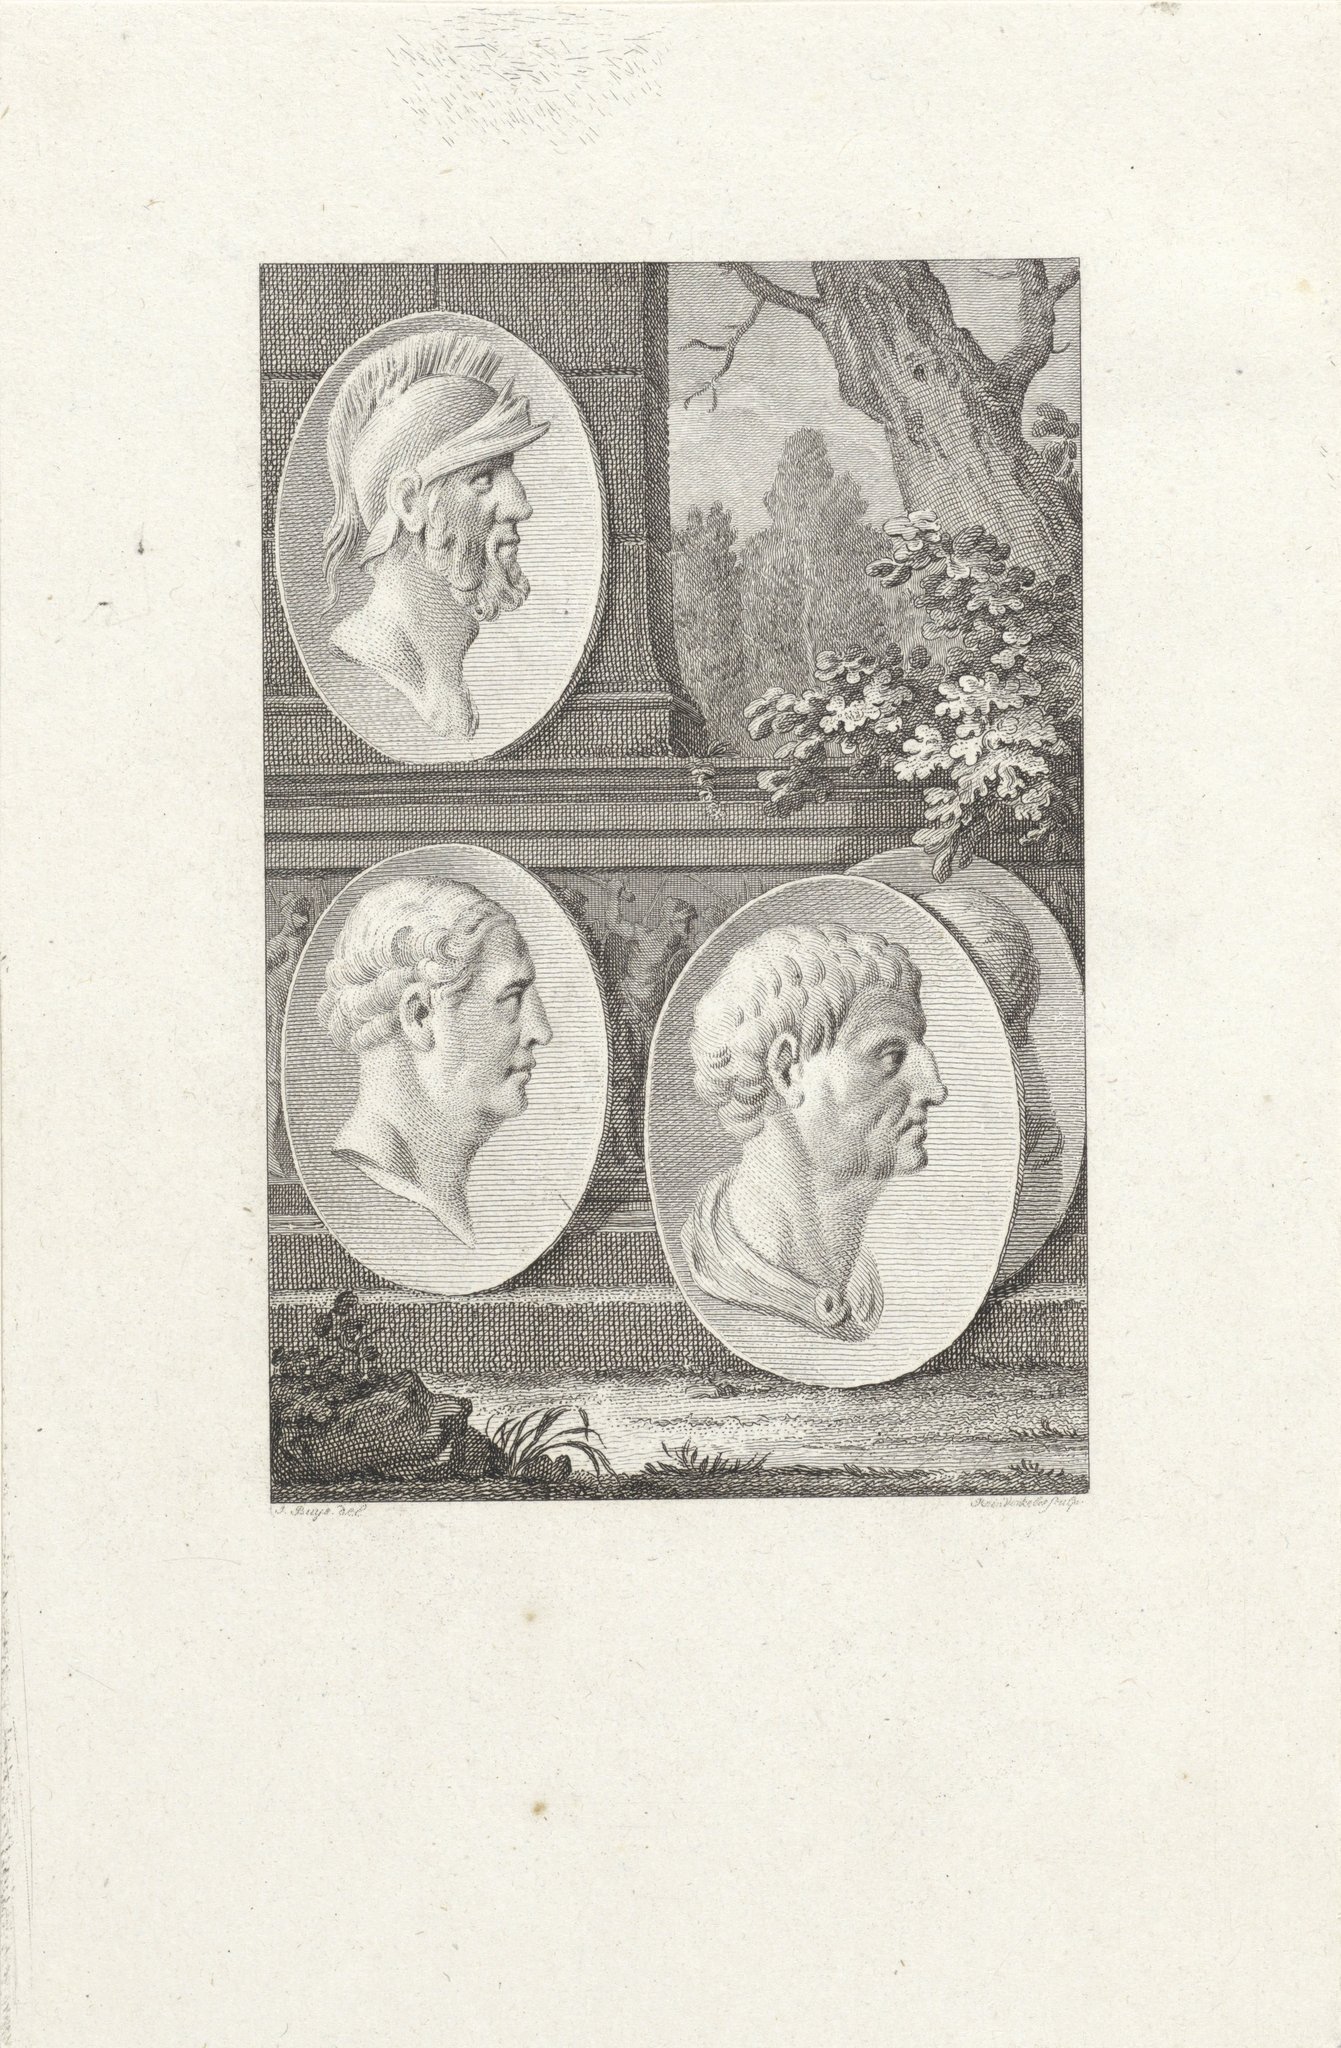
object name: print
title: Medaillons met portretten van Pyrrhus, Gaius Marius, Sulla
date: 1789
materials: paper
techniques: etching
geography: amsterdam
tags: (story of) gaius marius, (story of) pyrrhus, king of epirus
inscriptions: collector's mark: Lugt 240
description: Latere staat prent ook gebruikt als boekillustratie in: Plutarchus [bewerkt door E. Wassenbergh en H. Bosscha]. De levens van doorluchtige Grieken en Romeinen, onderling vergeleeken (...). 12 dln. Amsterdam: Johannes Allart, 1789-1809.